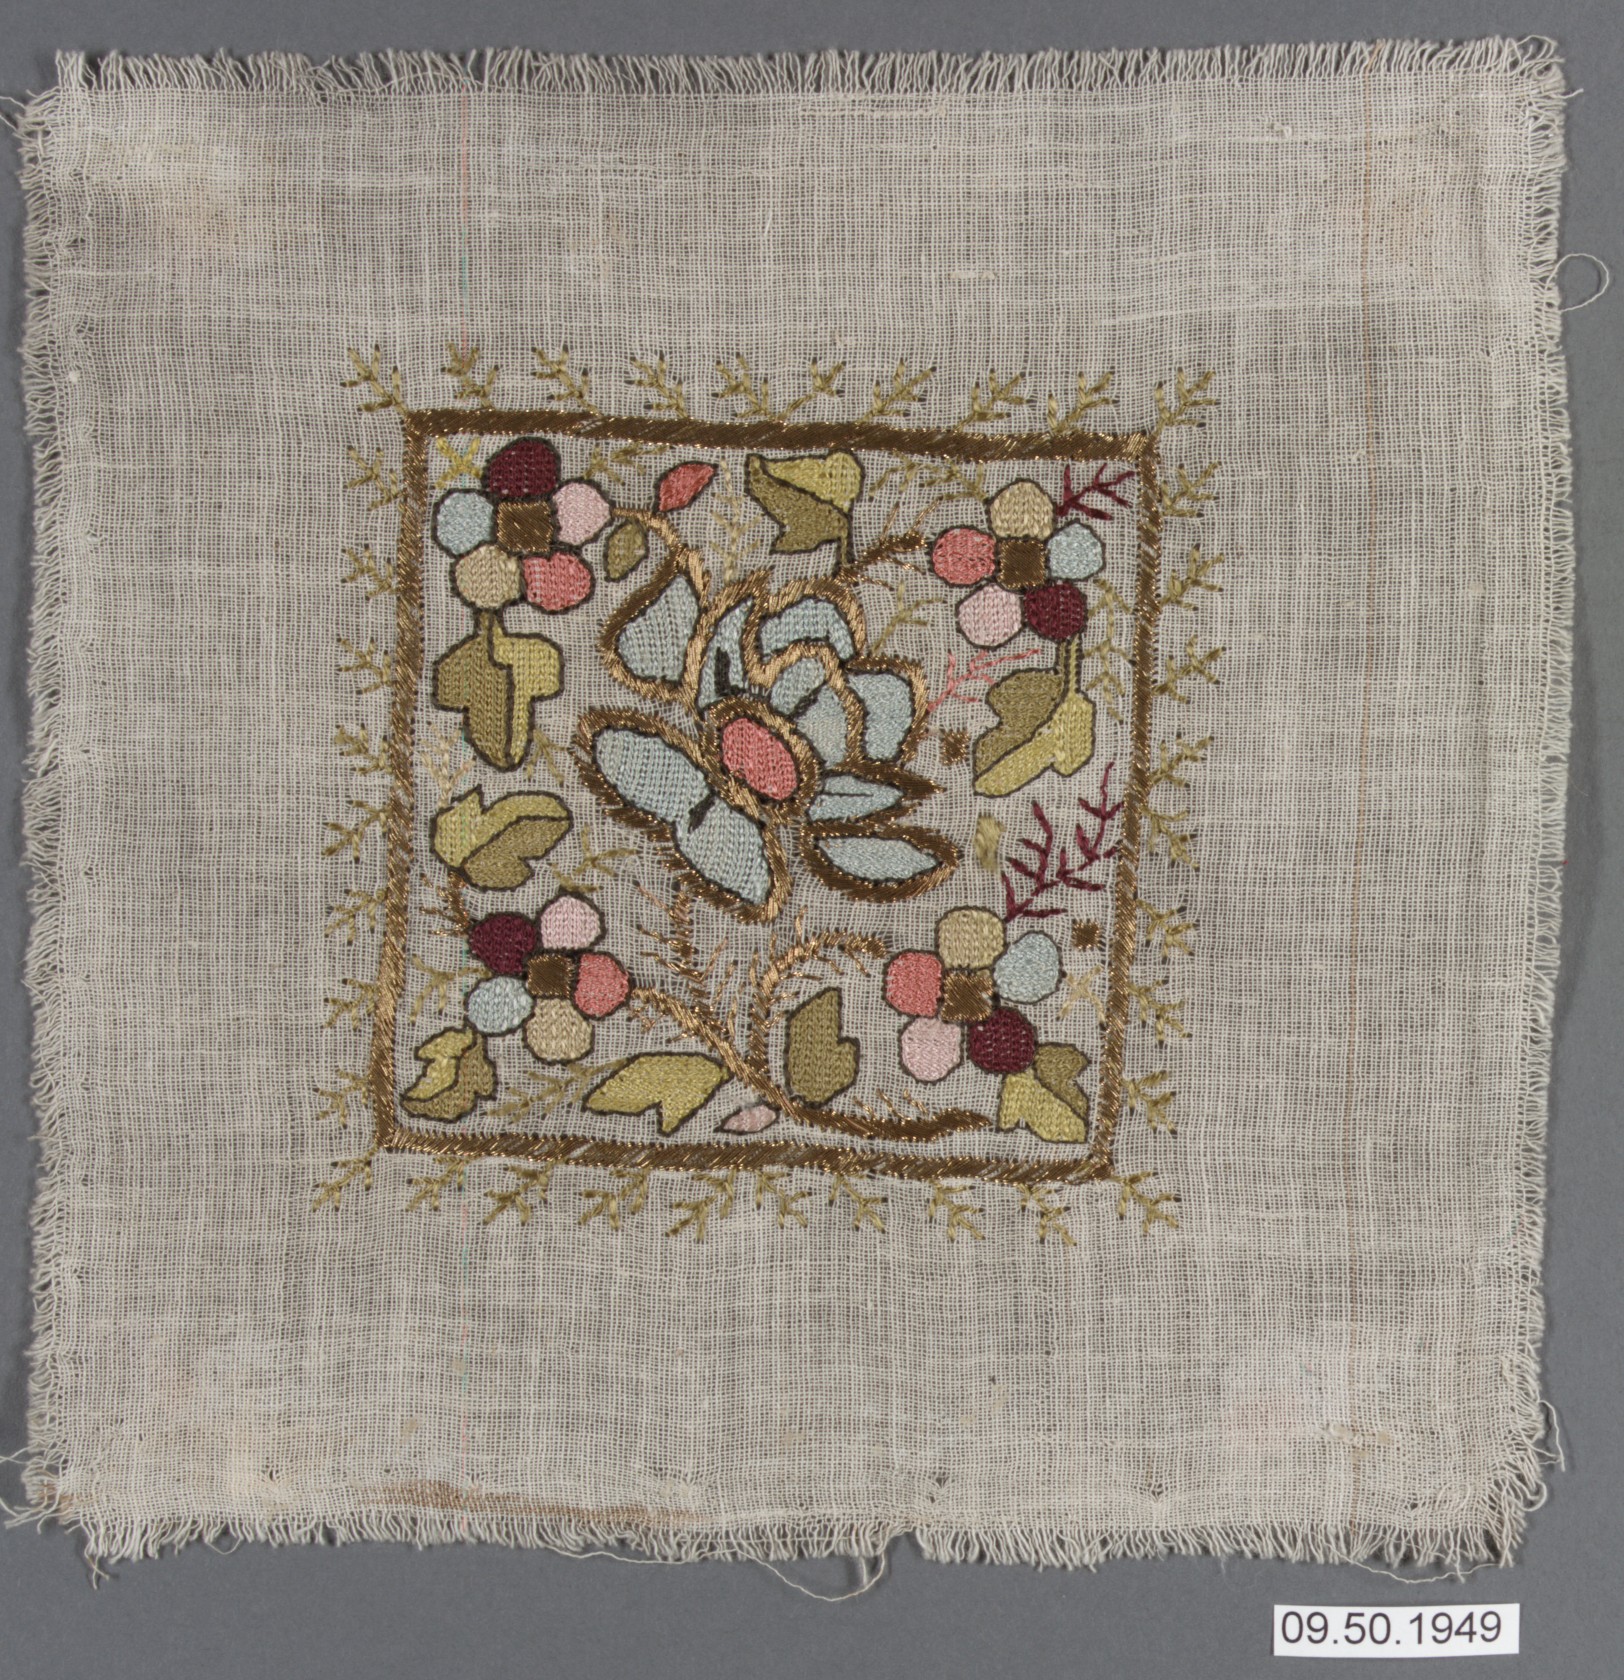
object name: square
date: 1801-1900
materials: gold thread, linen, silk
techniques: embroidery, weave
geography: turkey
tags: flowers